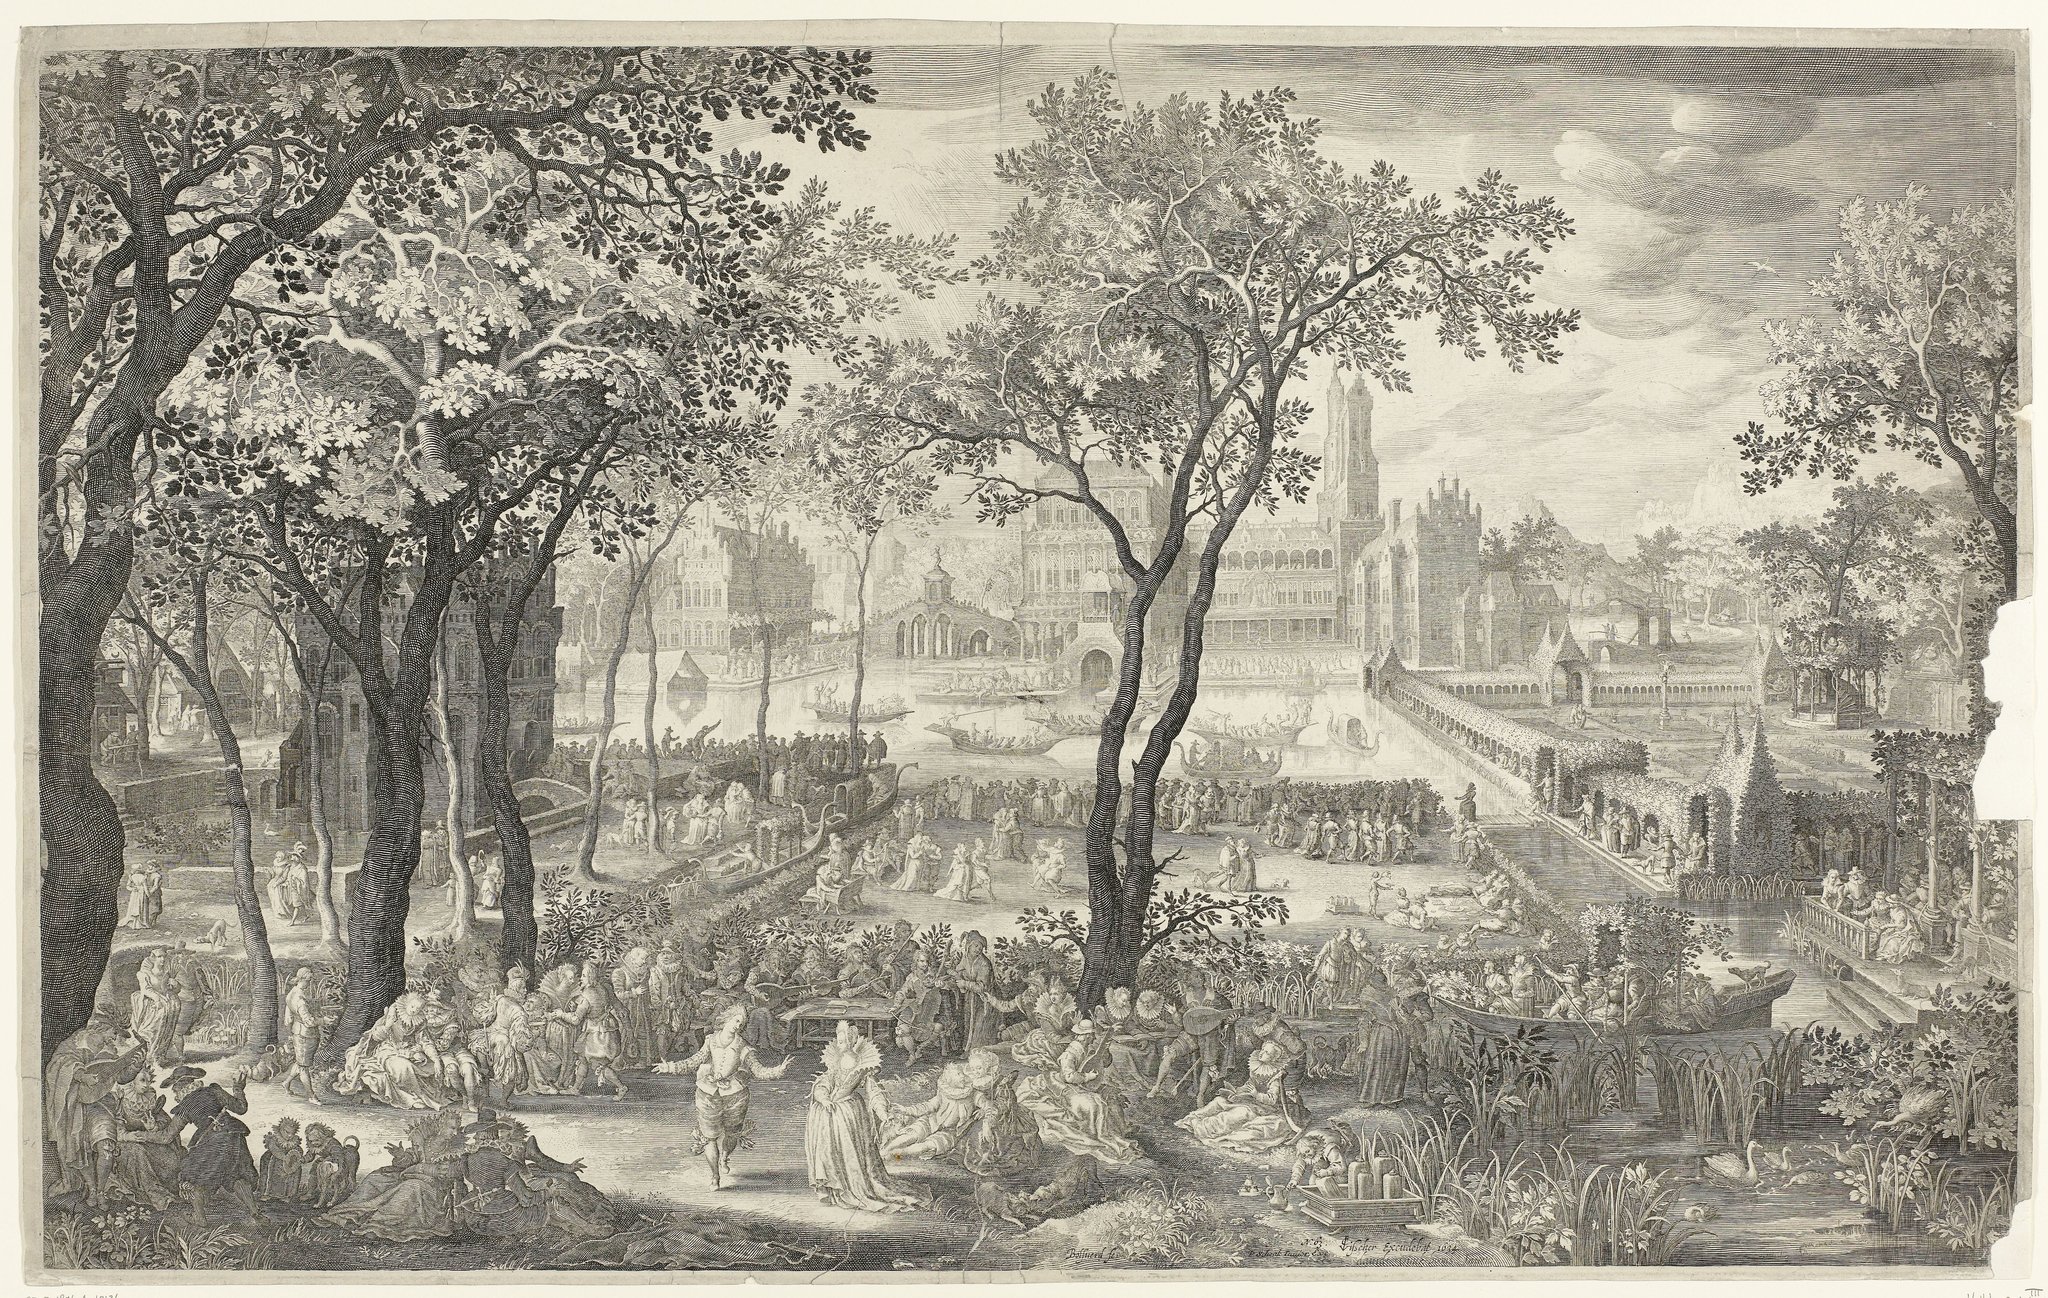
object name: print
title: Feest in tuin van kasteel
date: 1590-1633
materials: paper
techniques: engraving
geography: netherlands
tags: visiting; receiving guests; elegant company, garden, landscape with tower or castle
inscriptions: collector's mark: Lugt 2228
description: Prent naar ontwerp van David Vinckboons.